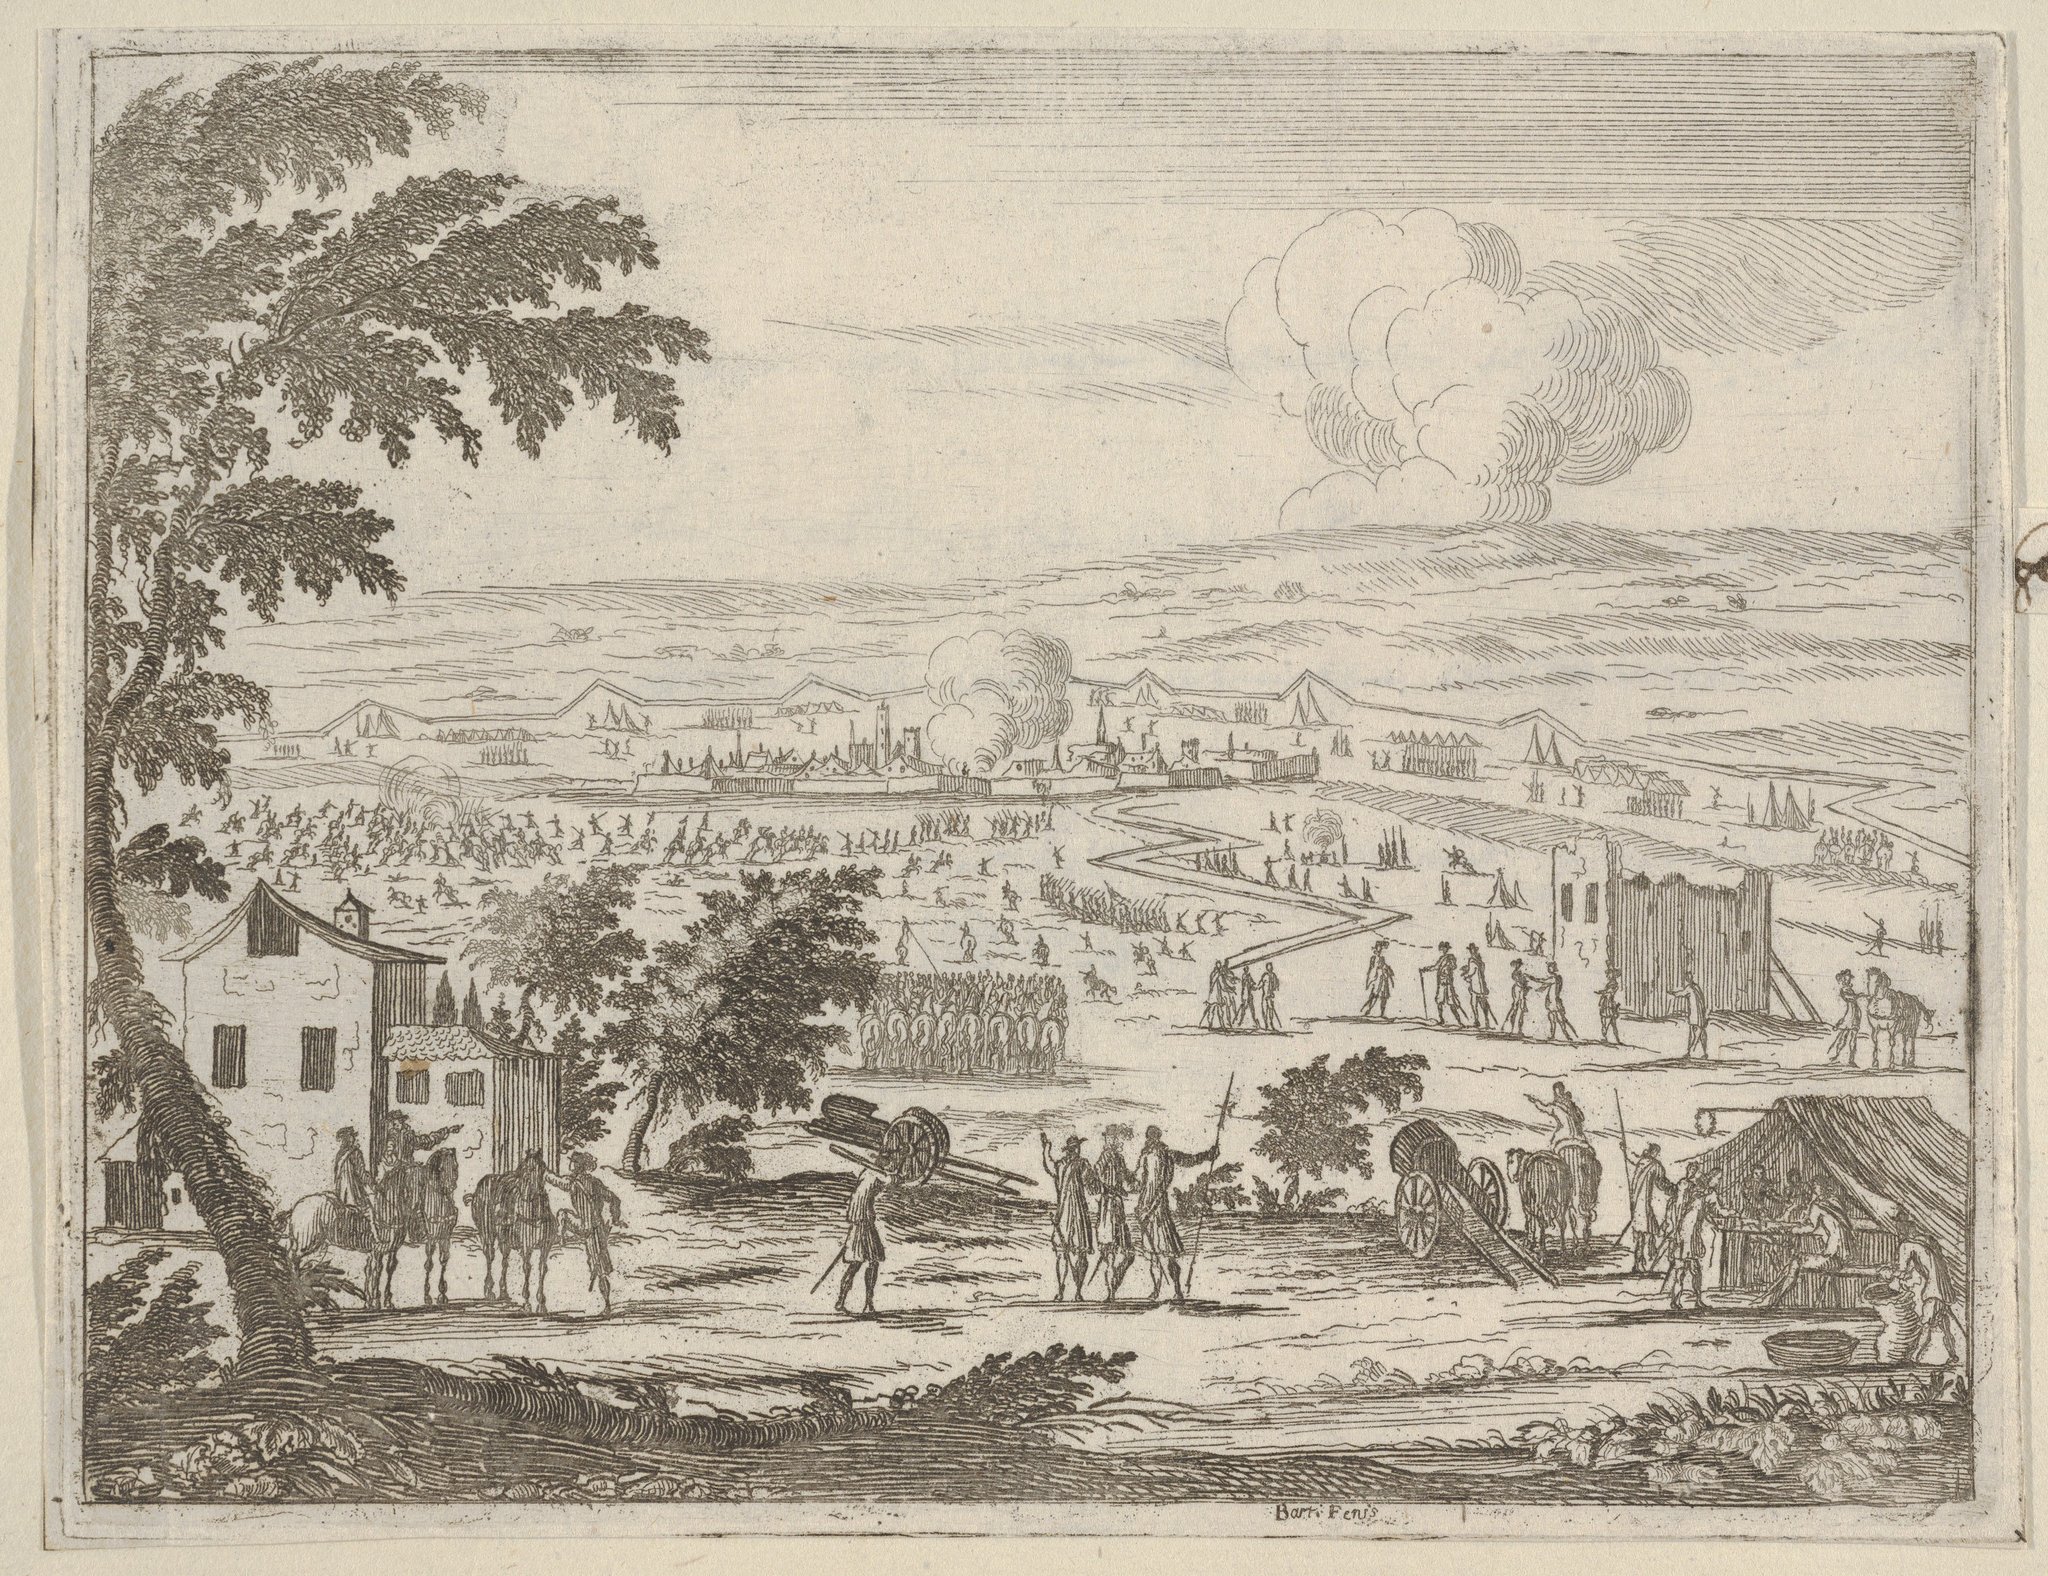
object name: print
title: Francesco I d'Este Suffers the Mortal Blow of a Bullet While Under Pavia and Retreats into his Own Quarters, Having Been Left Without Wounds to His Head and His Heart, which Gave Him a Fever, from "L'Idea di un Principe ed Eroe Cristiano in Francesco I d'Este, di Modena e Reggio Duca VIII [...]"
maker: bartolomeo fenice (fénis)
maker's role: artist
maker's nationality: italian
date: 1659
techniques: etching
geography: italy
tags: battles,soldiers